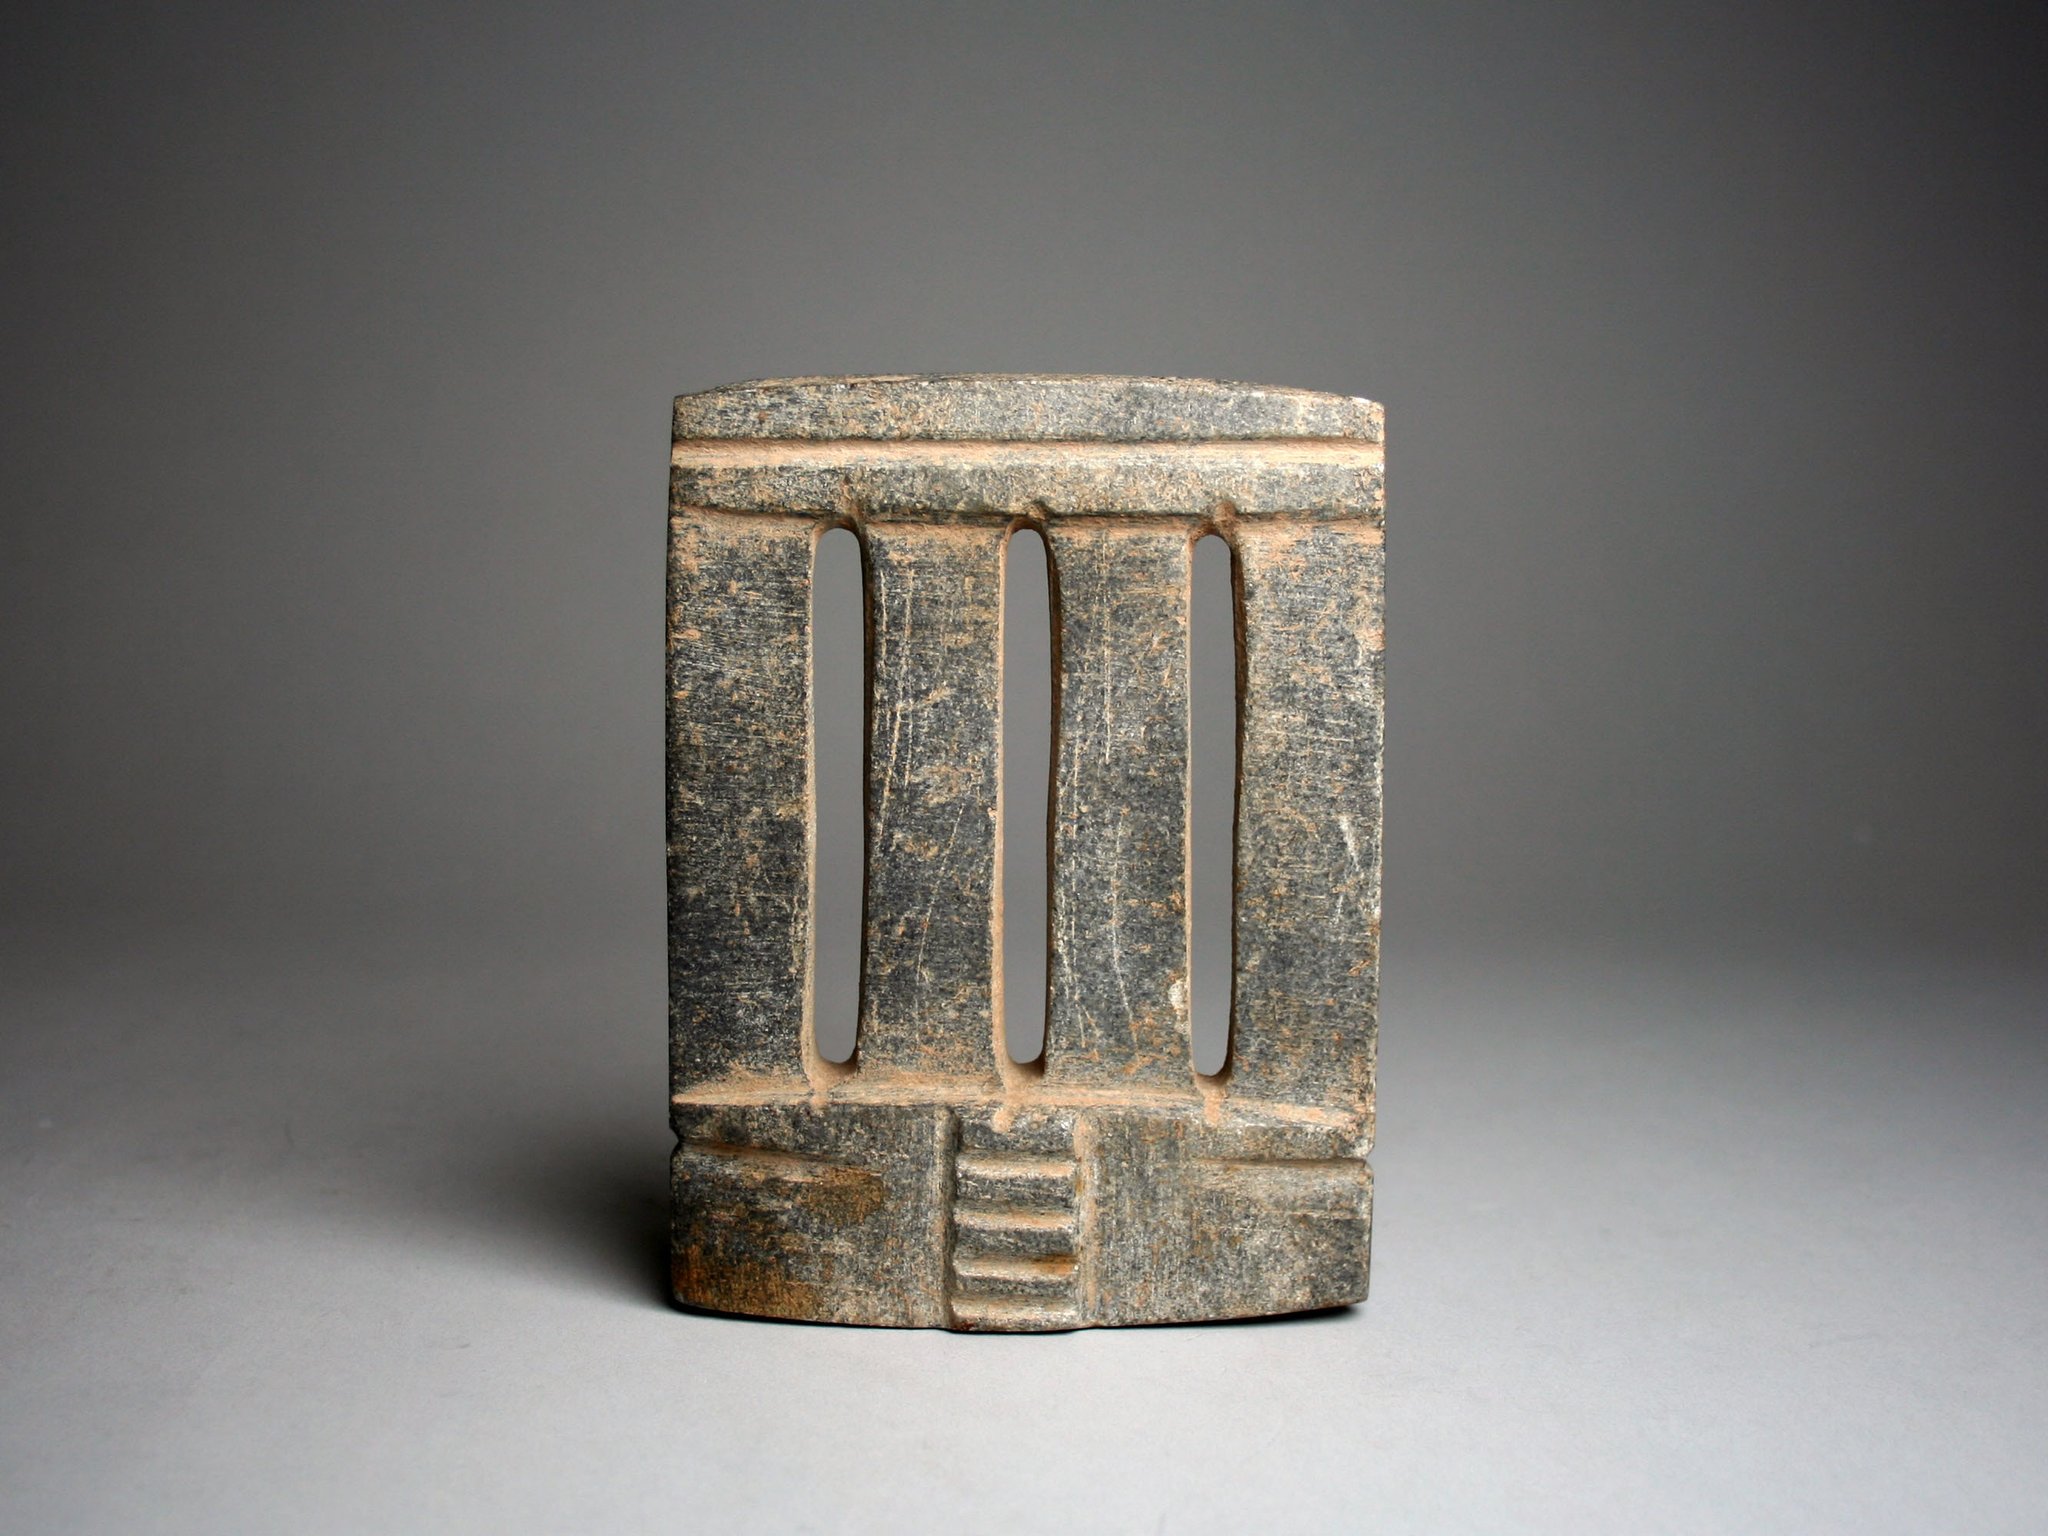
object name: architectural model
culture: mezcala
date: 1-800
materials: stone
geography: mexico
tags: temples